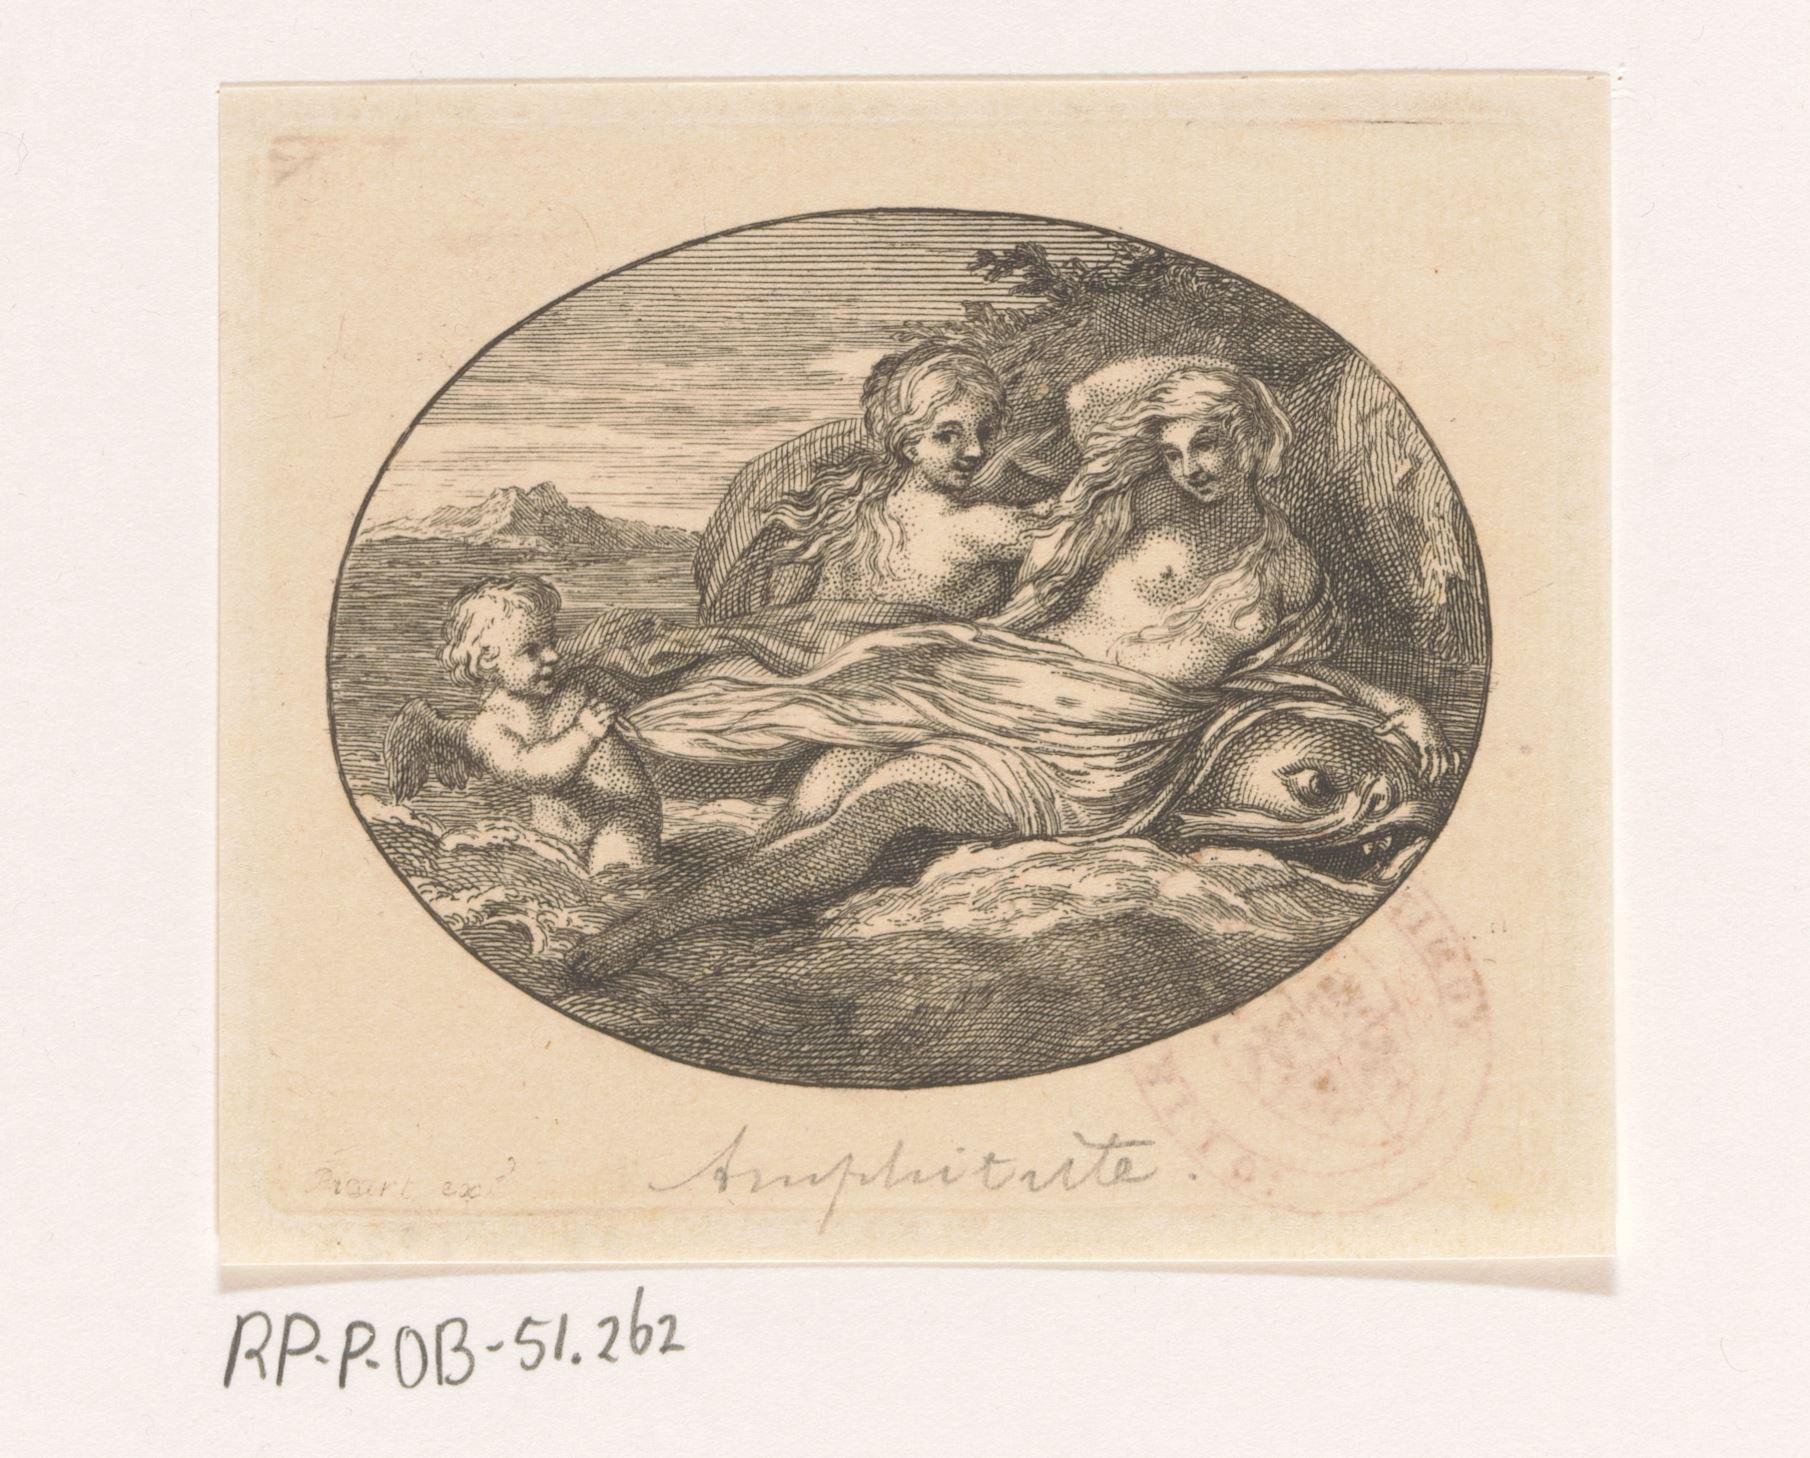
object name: print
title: Amphitrite op een dolfijn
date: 1683-1733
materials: paper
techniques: etching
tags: amphitrite riding on a dolphin; possibly brought to neptune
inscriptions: collector's mark: Lugt 240